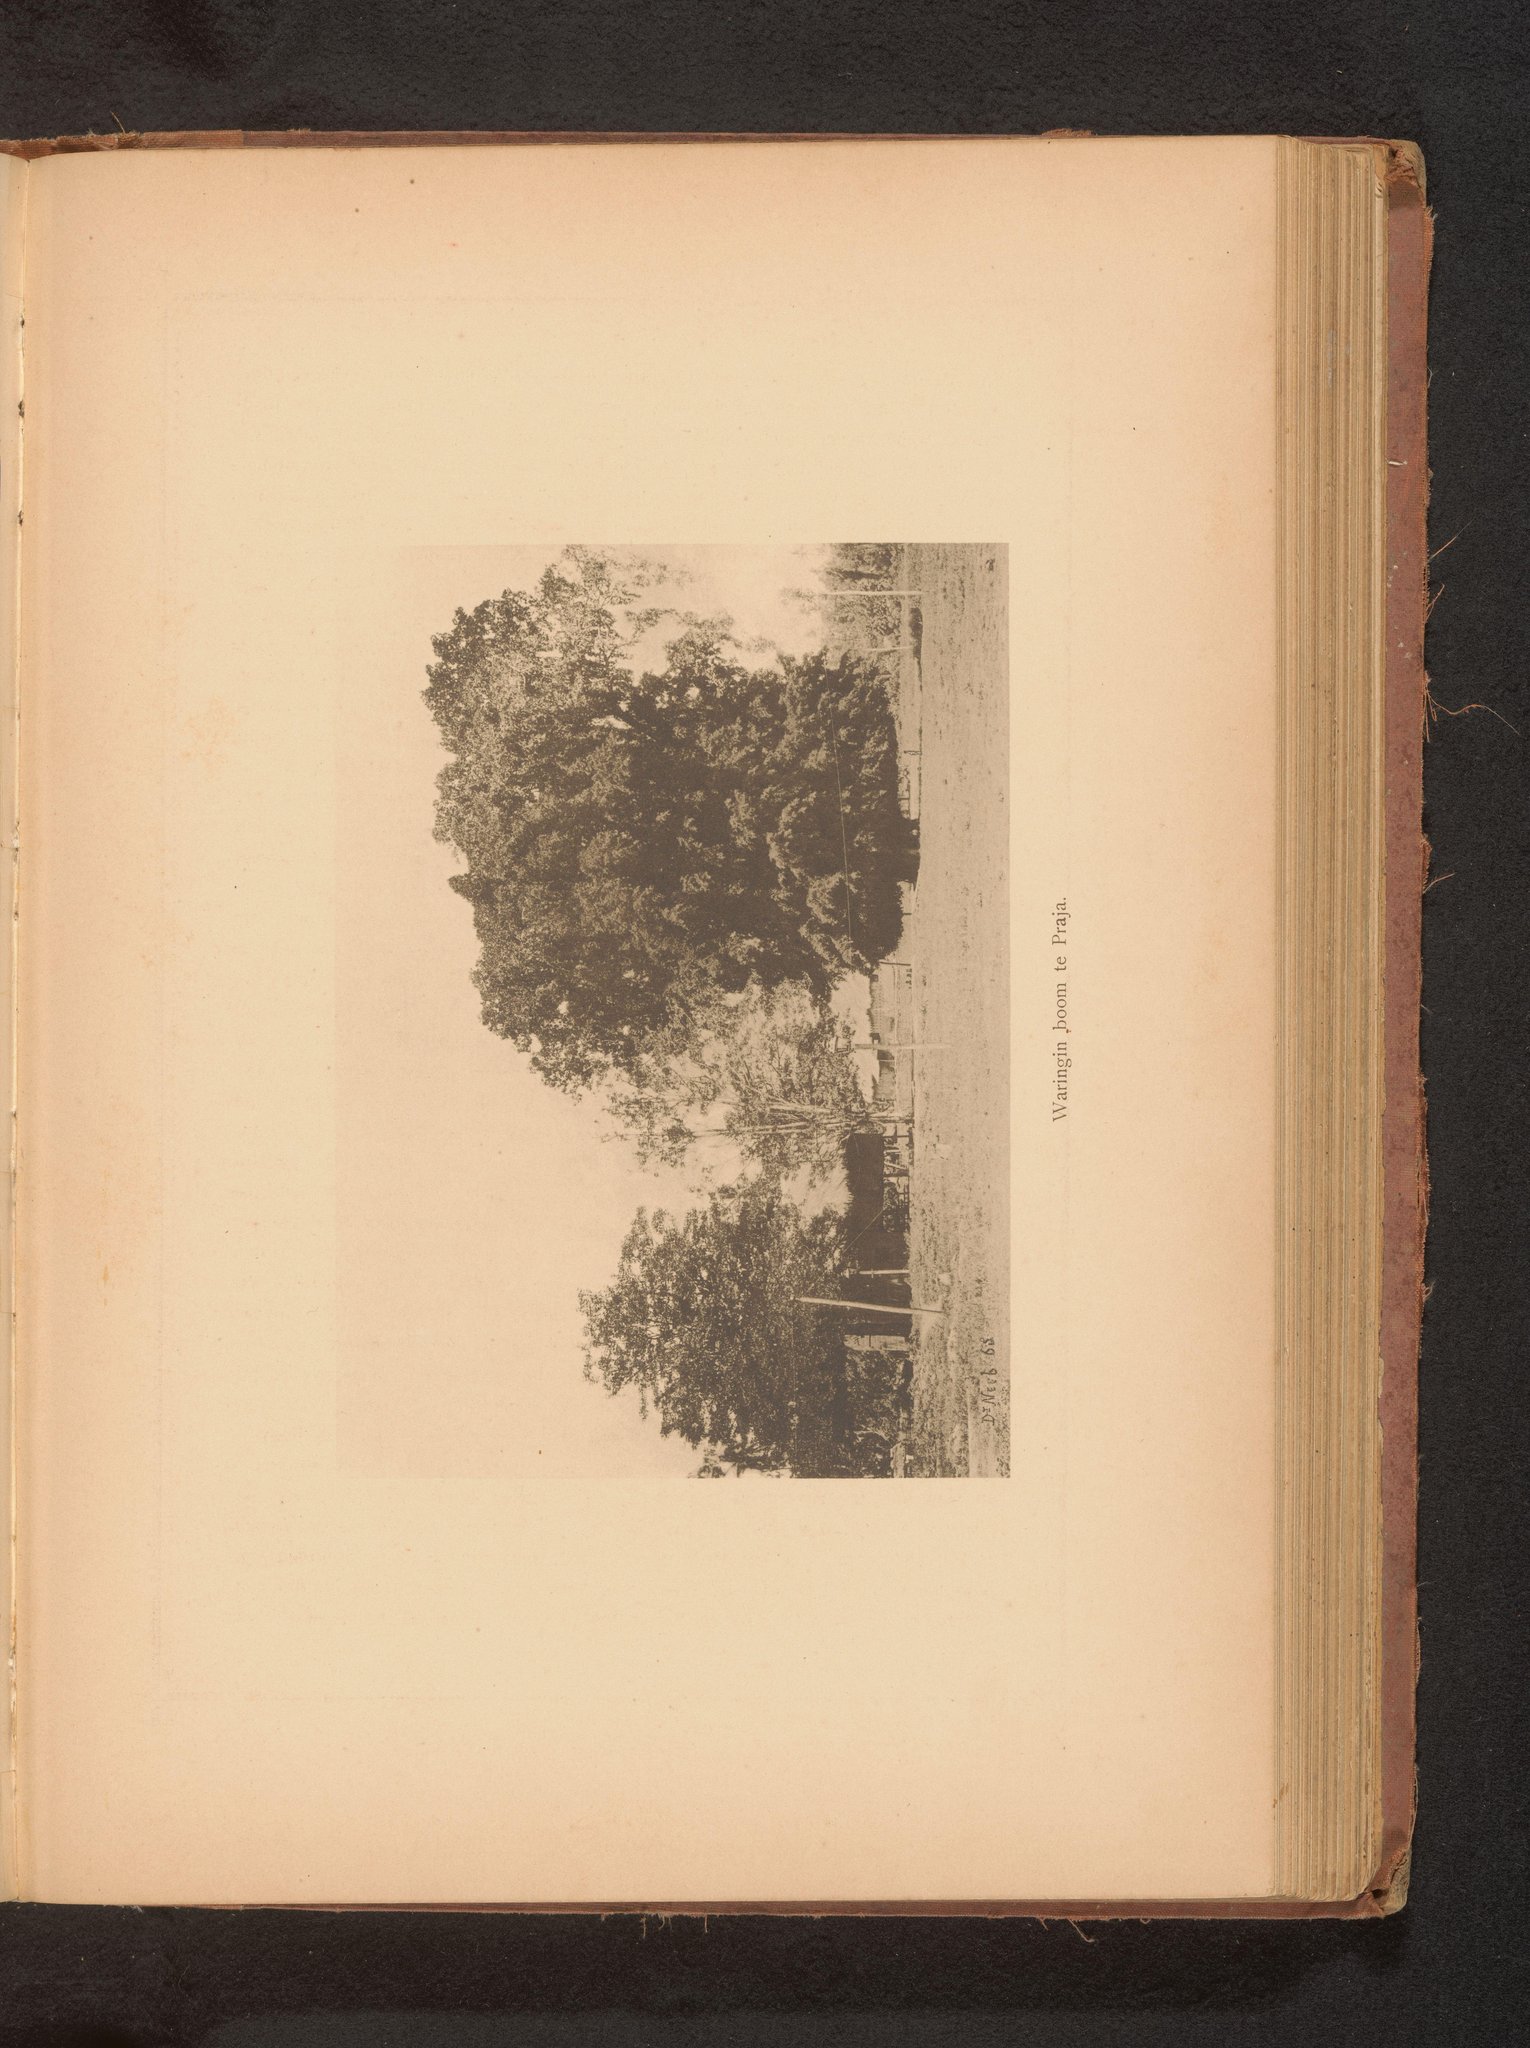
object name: page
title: Waringin boom te Praja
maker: christiaan johan neeb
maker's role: arts, fotograaf, officier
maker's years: 1860-1925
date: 1892-1897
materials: paper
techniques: photograph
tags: trees, indonesia